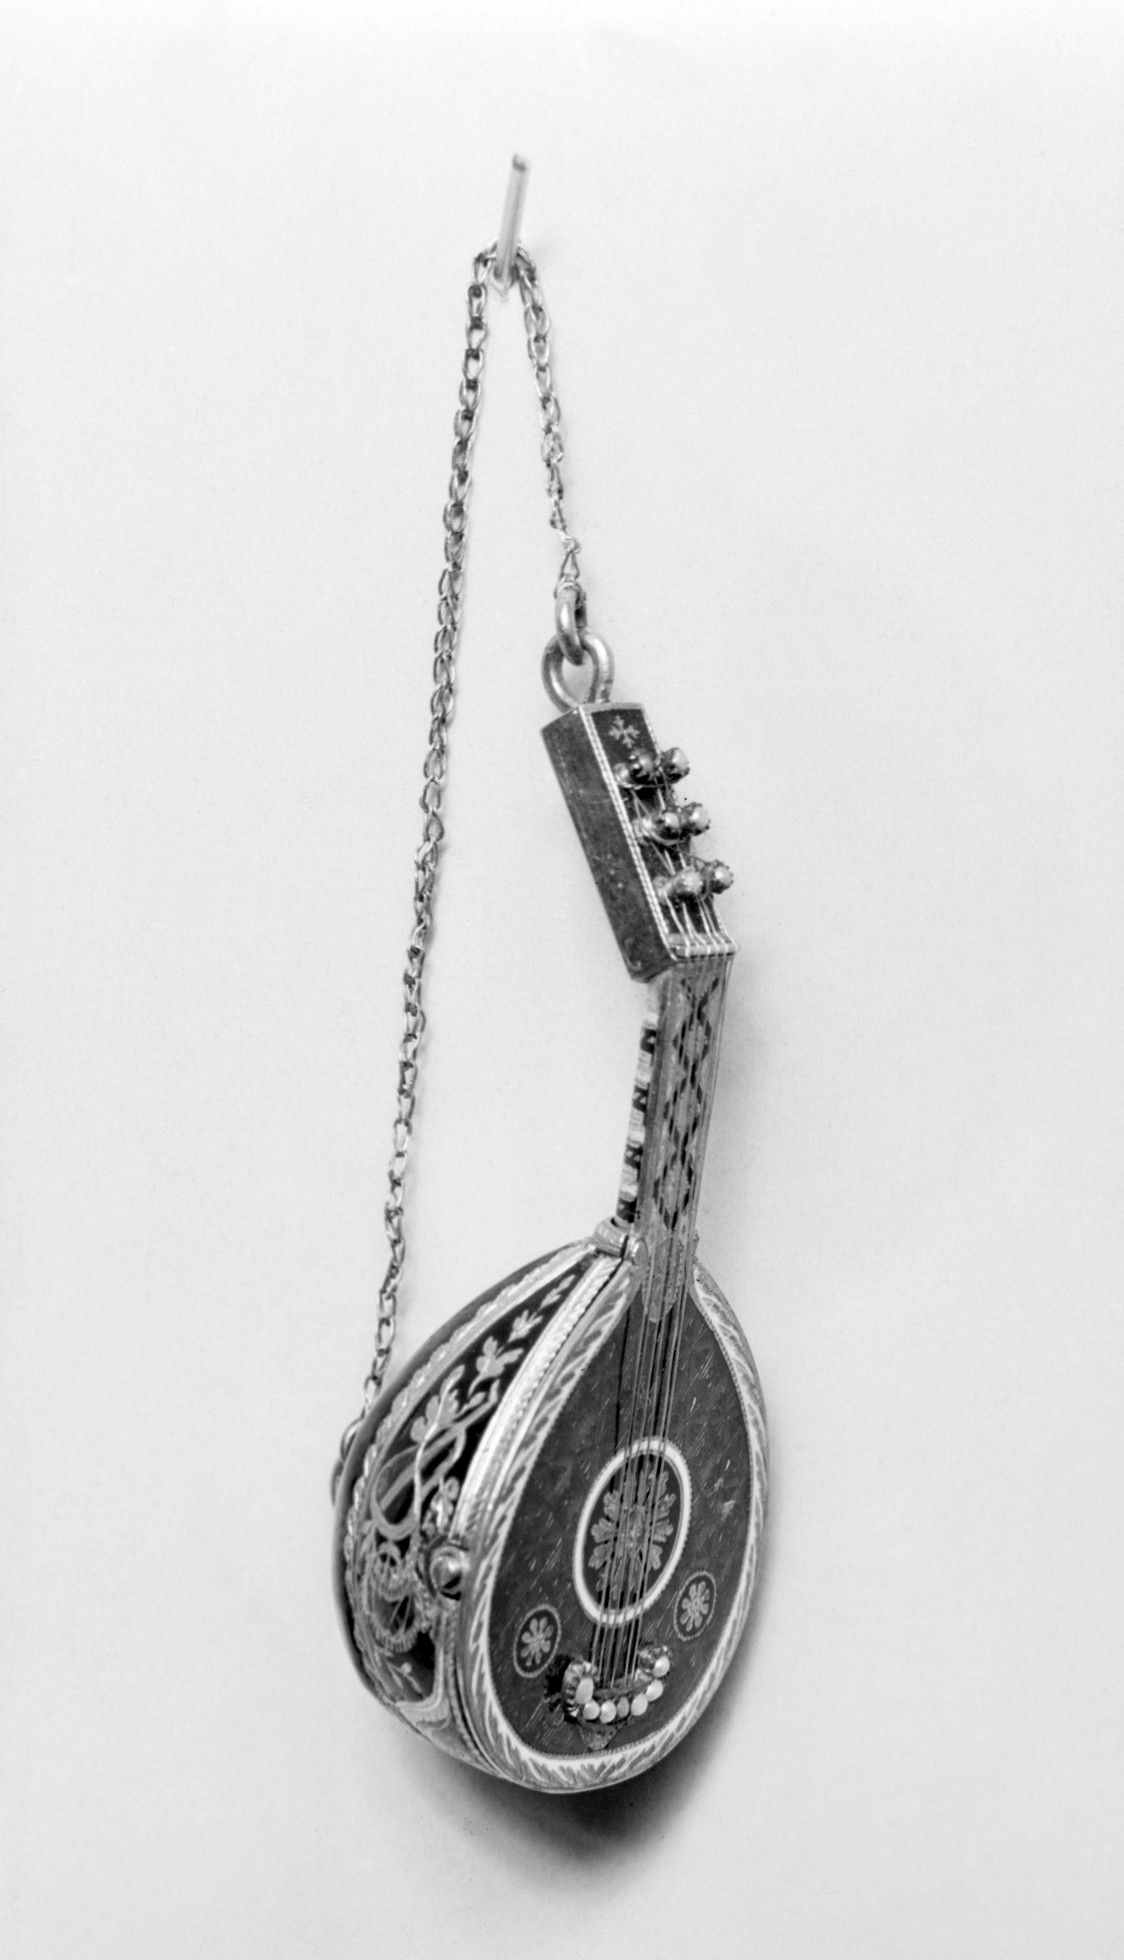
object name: watch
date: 1801-1833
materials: enamel, gold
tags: lutes